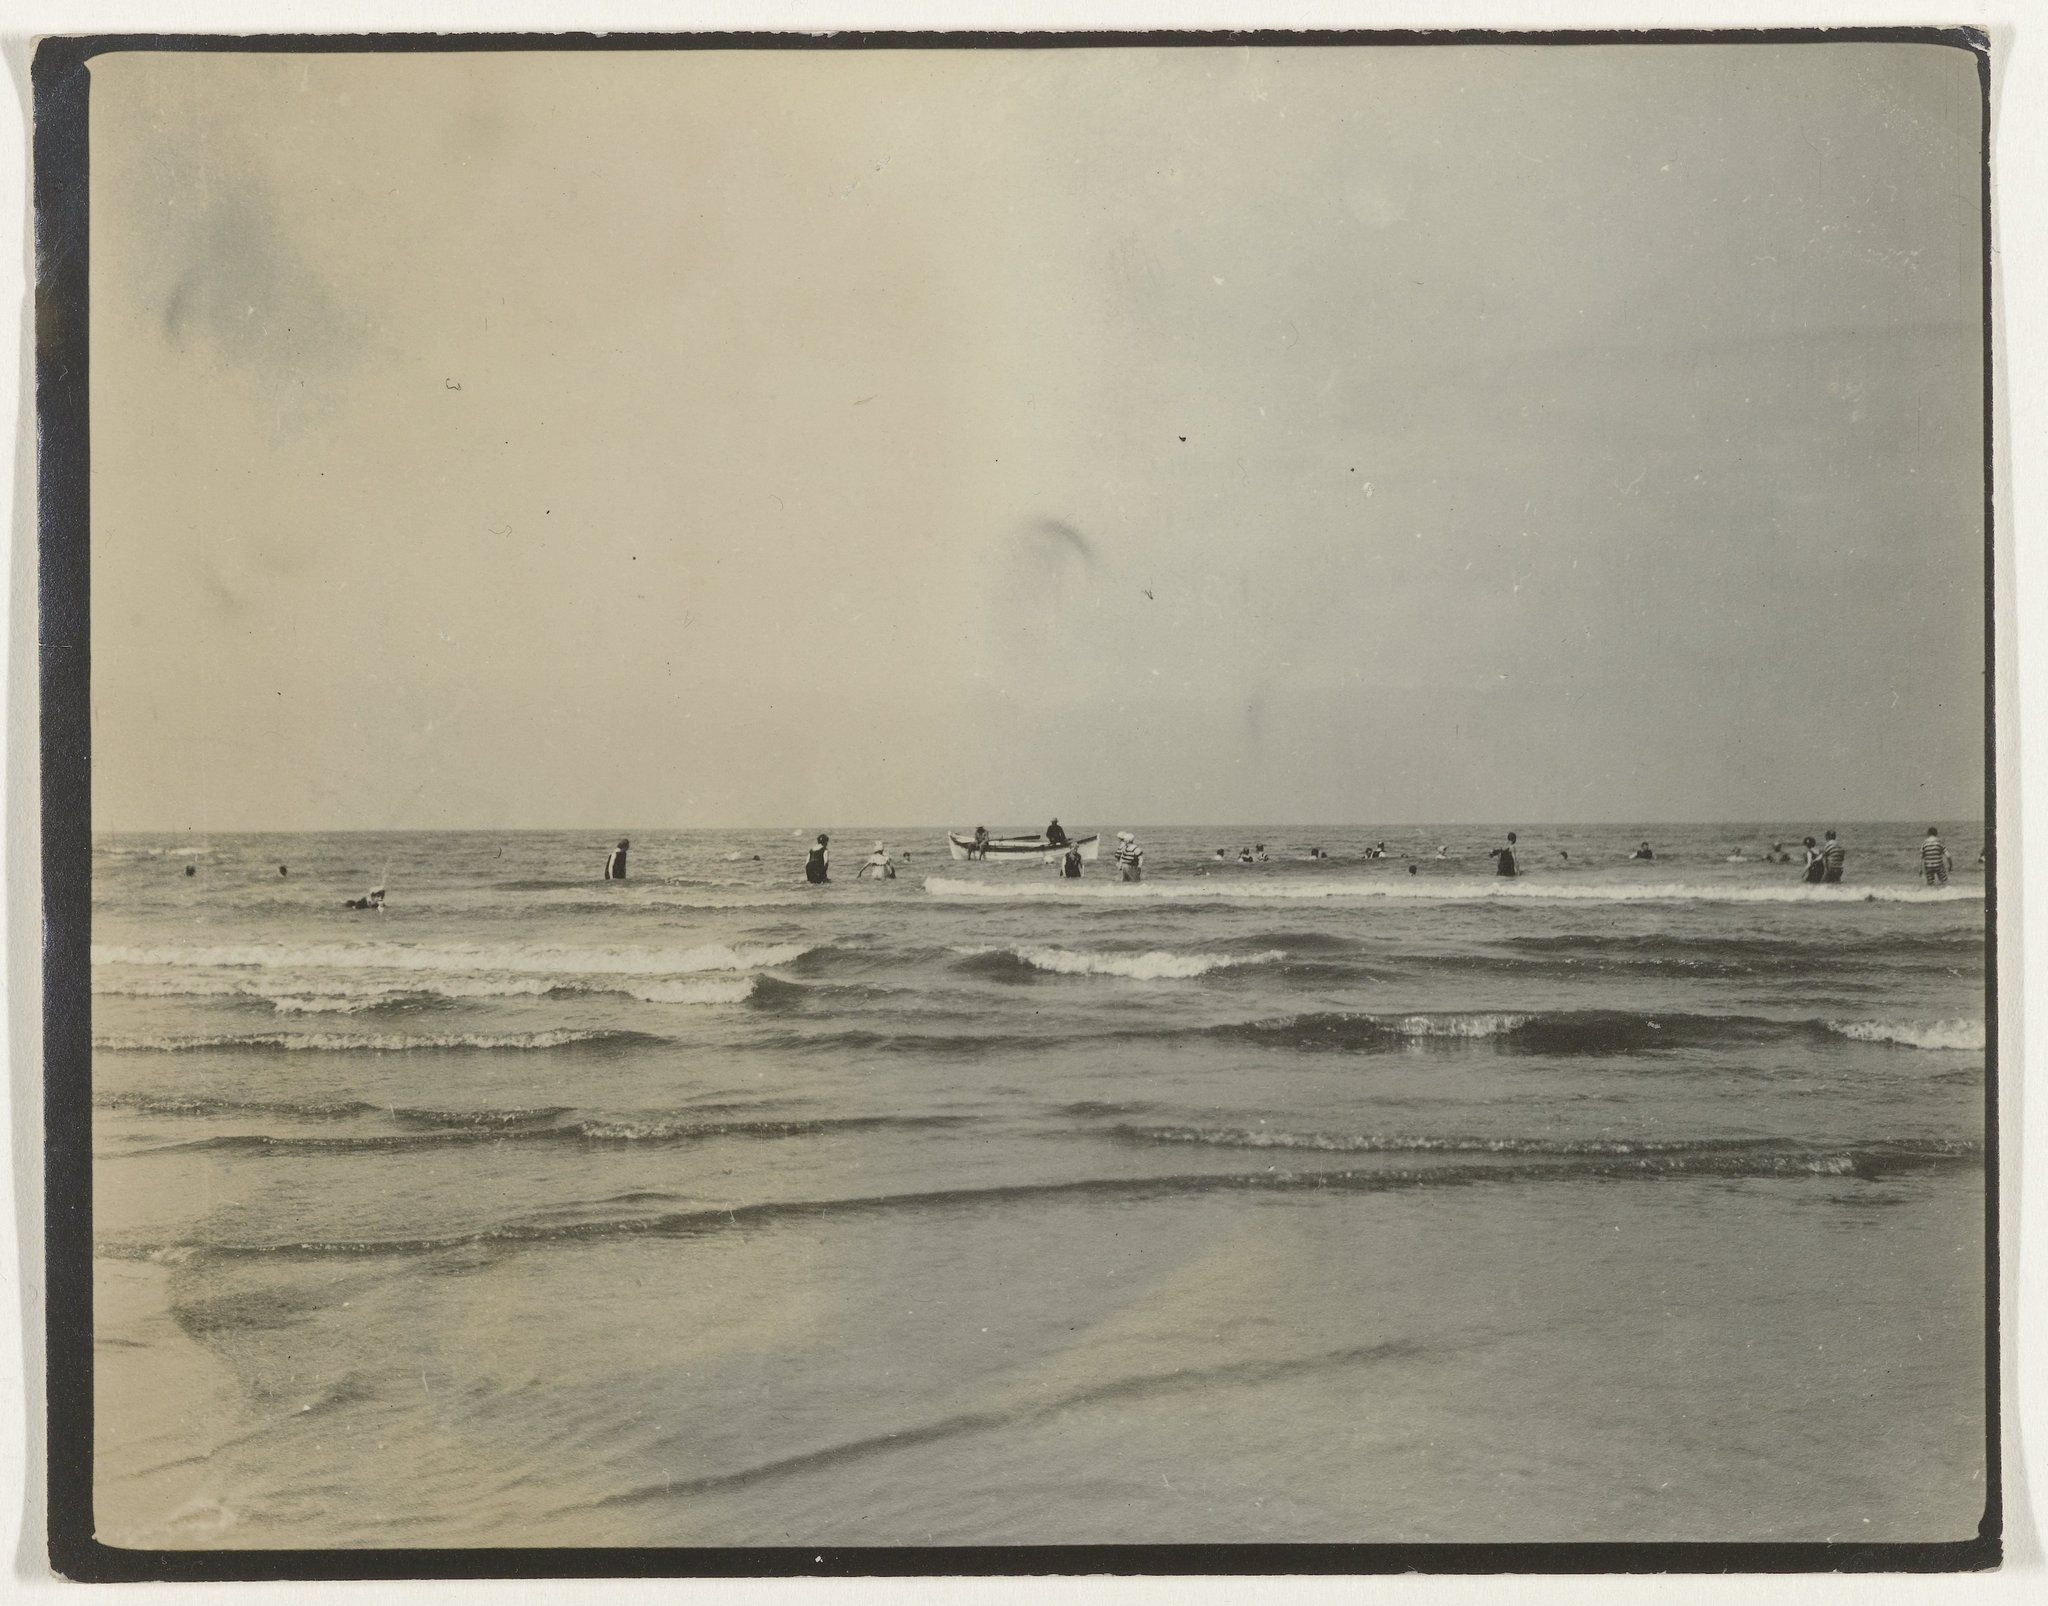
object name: photograph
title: Zwemmende mensen in zee (Noordzeekust), Nederland of Duitsland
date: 1900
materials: paper, photographic support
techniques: gelatin silver print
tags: beach (as place of recreation), netherlands, germany